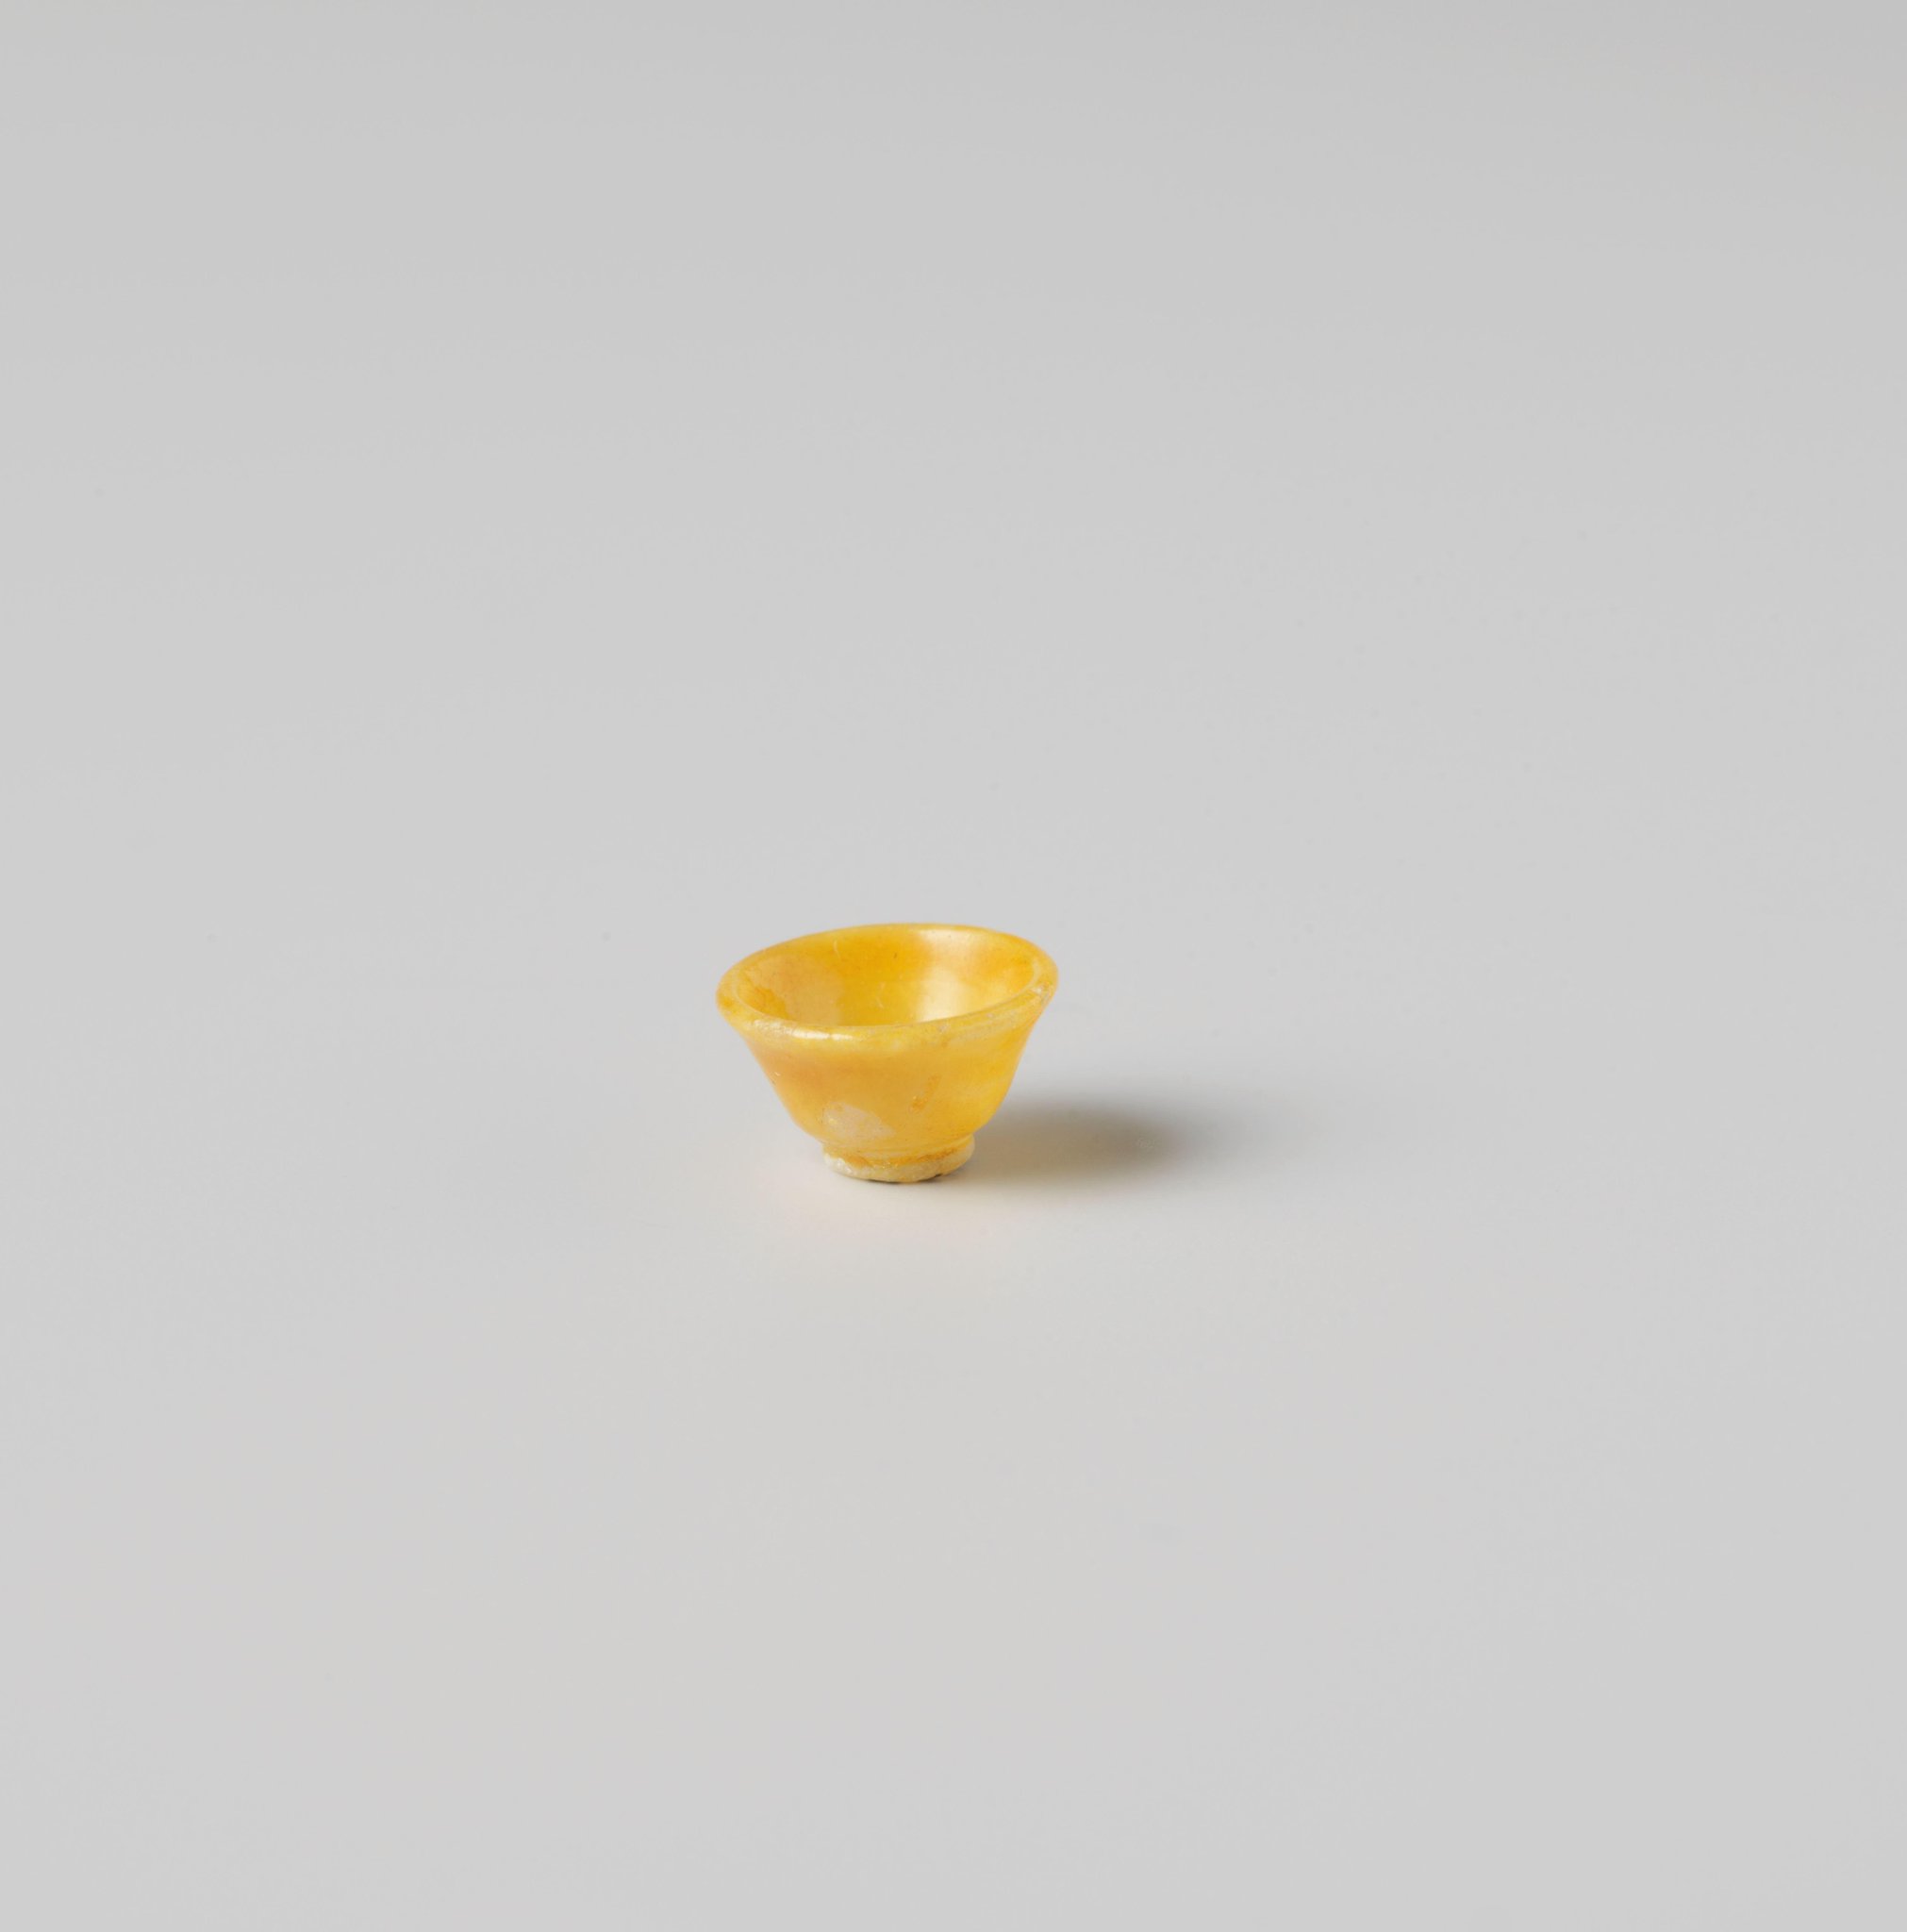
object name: cup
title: Kom, geelgelakt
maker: Anonymous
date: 1750-1800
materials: alabaster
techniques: lacquer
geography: germany